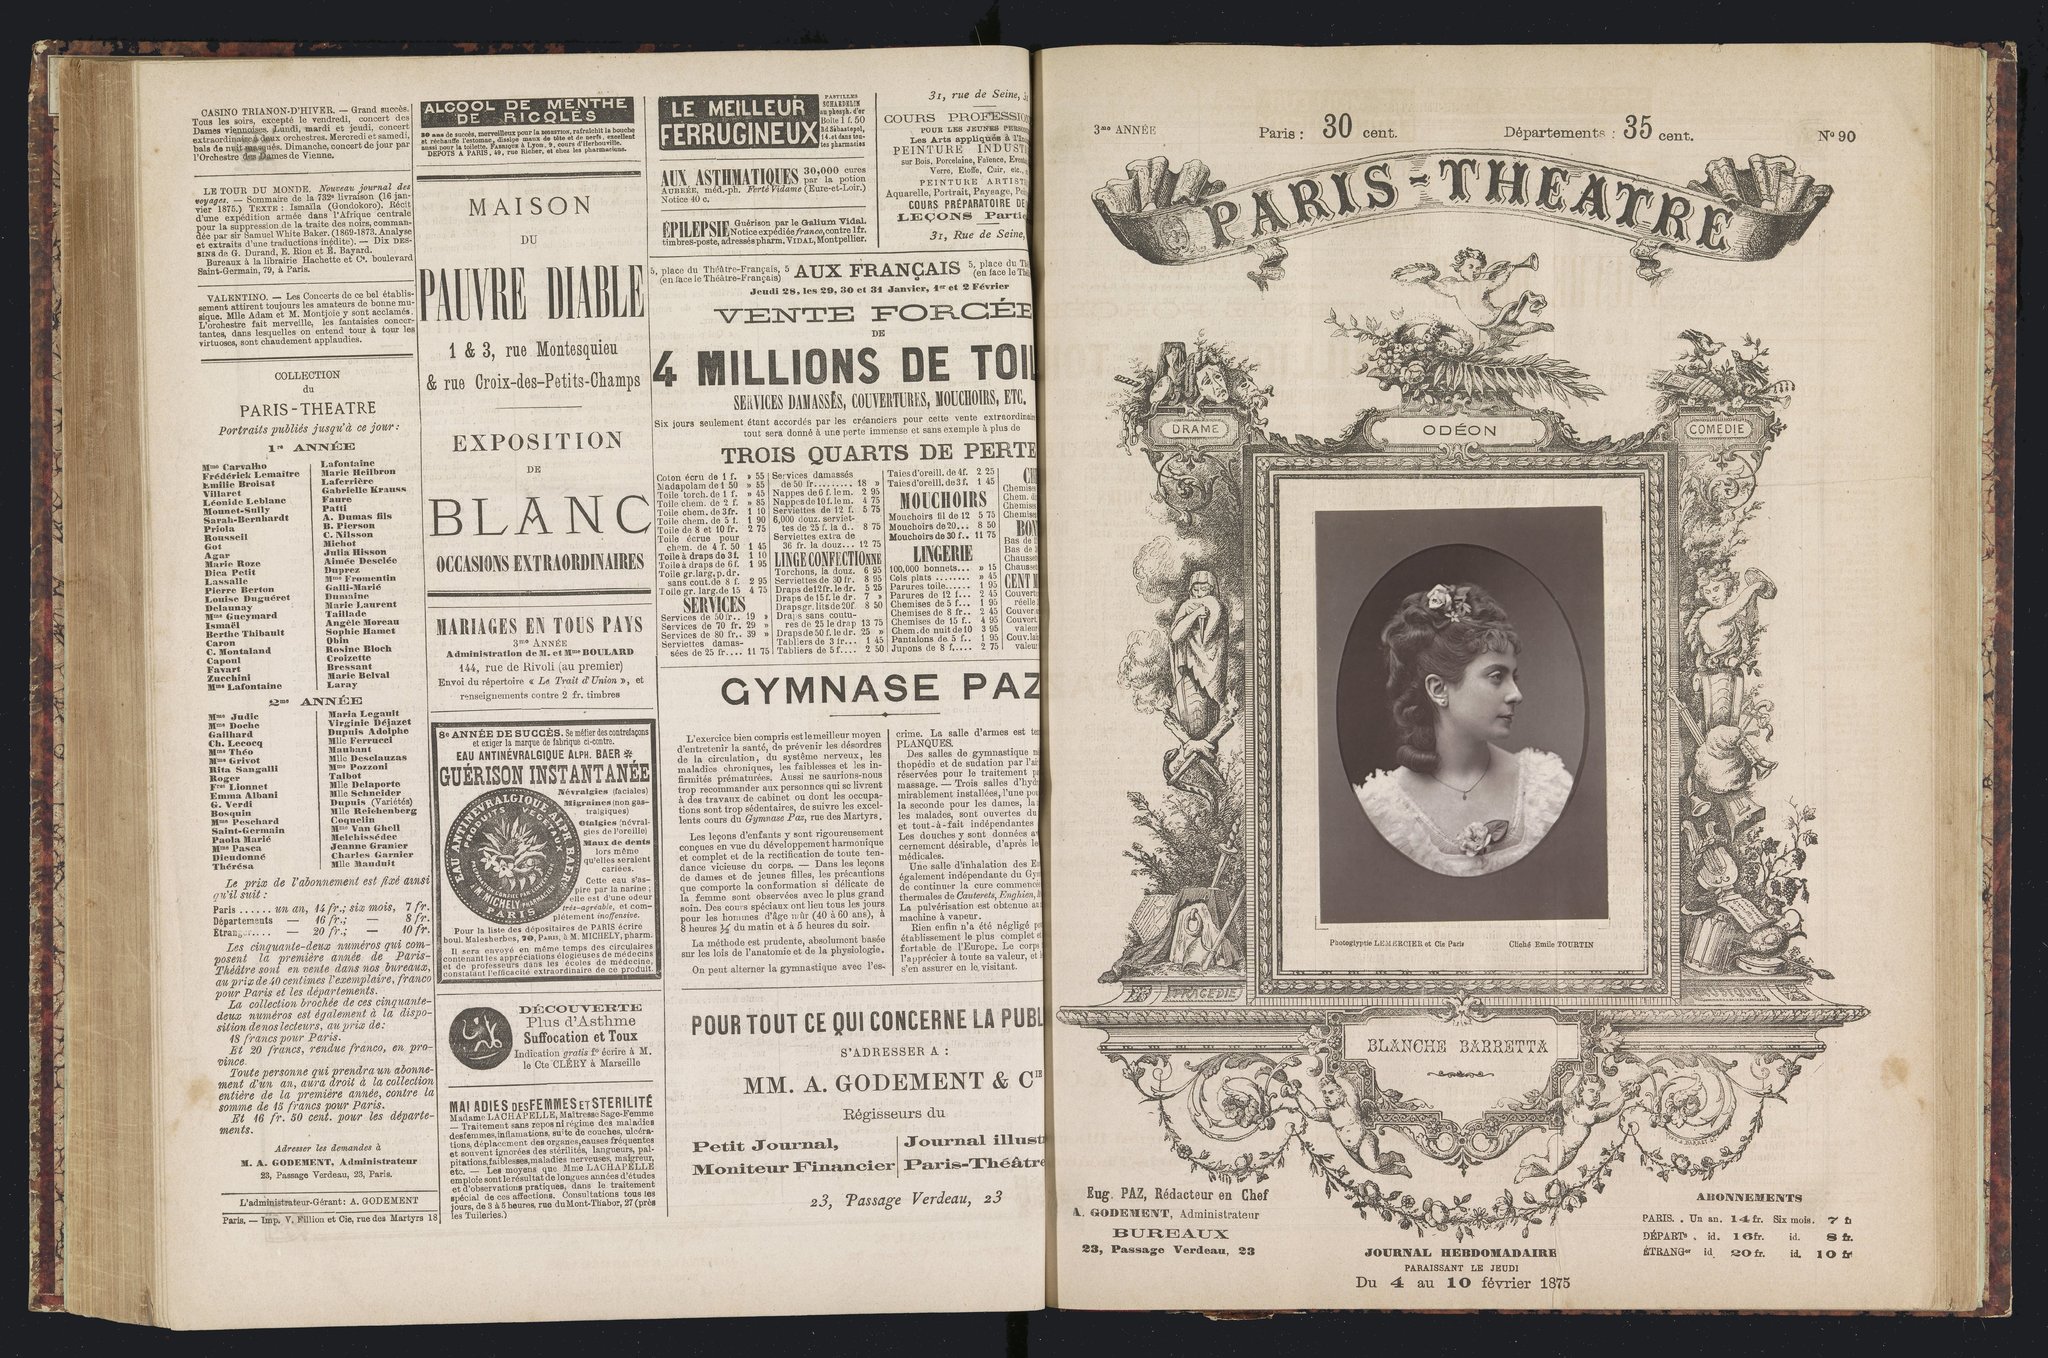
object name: page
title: Portret van Blanche Barretta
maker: emile tourtin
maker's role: fotograaf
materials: paper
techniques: woodburytype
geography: france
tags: portrait of actor, actress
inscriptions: number: ‘No 90’, inscription: ‘Journal hebdomadaire paraissant le jeudi Du 4 au 10 février 1875’